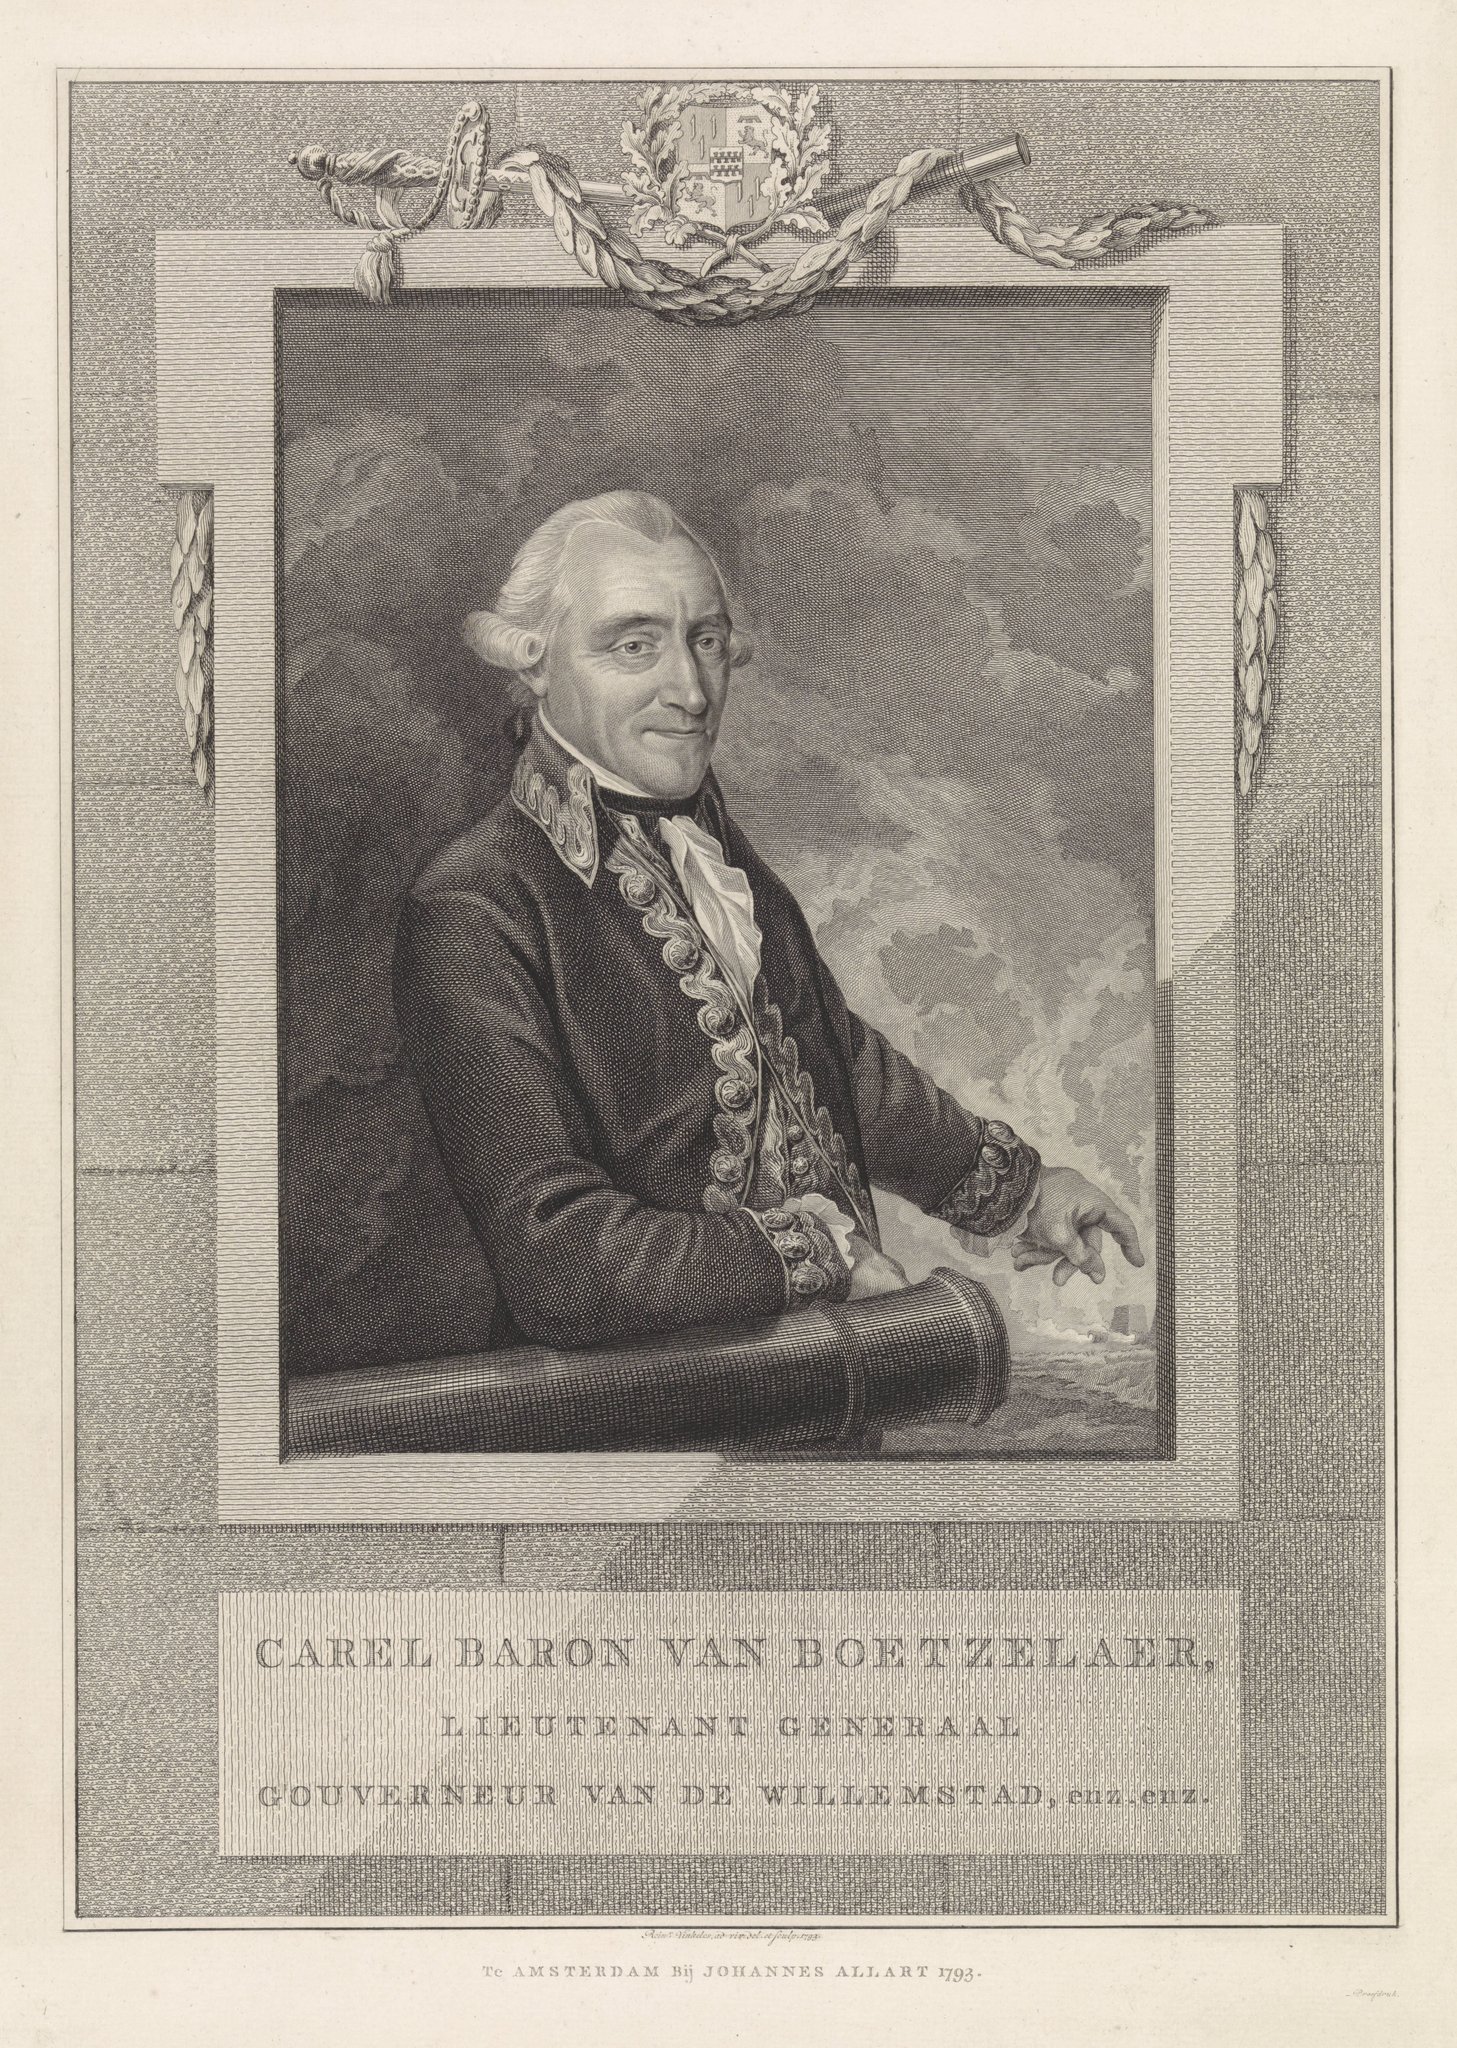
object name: print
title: Portret van Carel baron van Boetzelaer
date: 1793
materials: paper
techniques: engraving, etching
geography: amsterdam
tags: historical persons, firearms: cannon, armorial bearing, heraldry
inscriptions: collector's mark: Lugt 240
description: Portret van Carel baron van Boetzelaer, luitenant-generaal en gouverneur van Willemstad. Onder het portret zijn naam en gegevens in drie regels in het Nederlands.